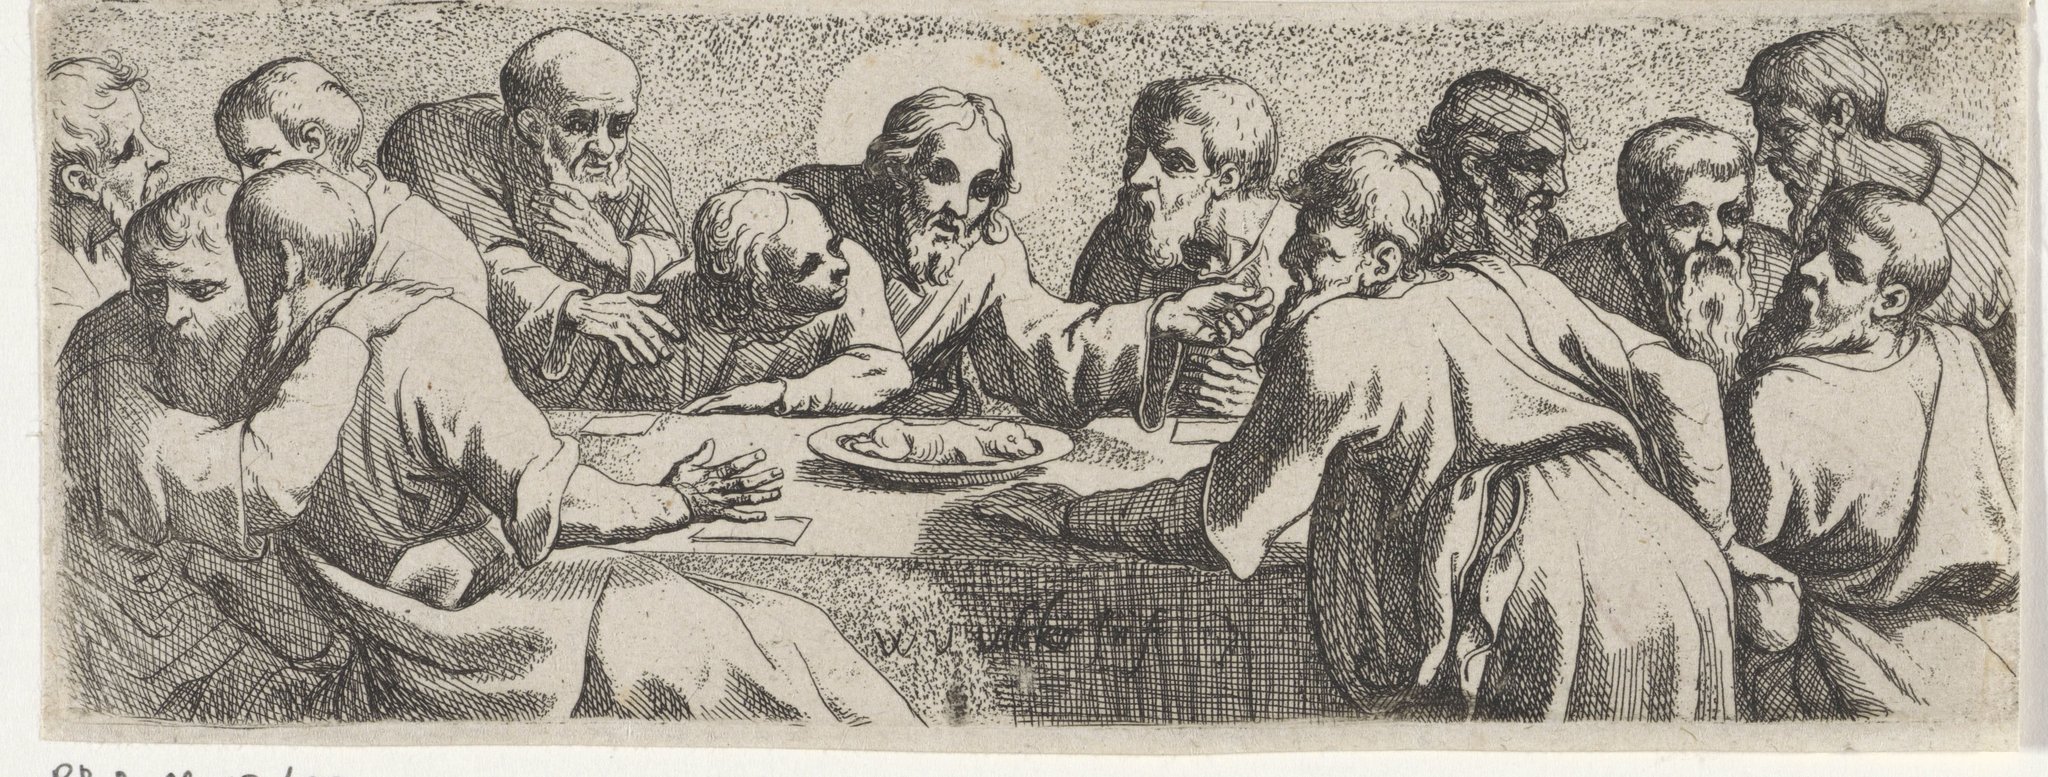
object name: print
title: Laatste Avondmaal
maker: werner van den valckert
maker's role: draughtsman, painter, print maker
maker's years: 1580-1627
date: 1595-1645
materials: paper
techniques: etching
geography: northern netherlands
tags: last supper (in general) (matthew 26:21-35; mark 14:18-31; luke 22:3, 22:15-23; john 13:21-38)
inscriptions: collector's mark: Lugt 240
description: Christus toont het gezegende brood aan de apostelen. Naast hem Johannes de Evangelist.